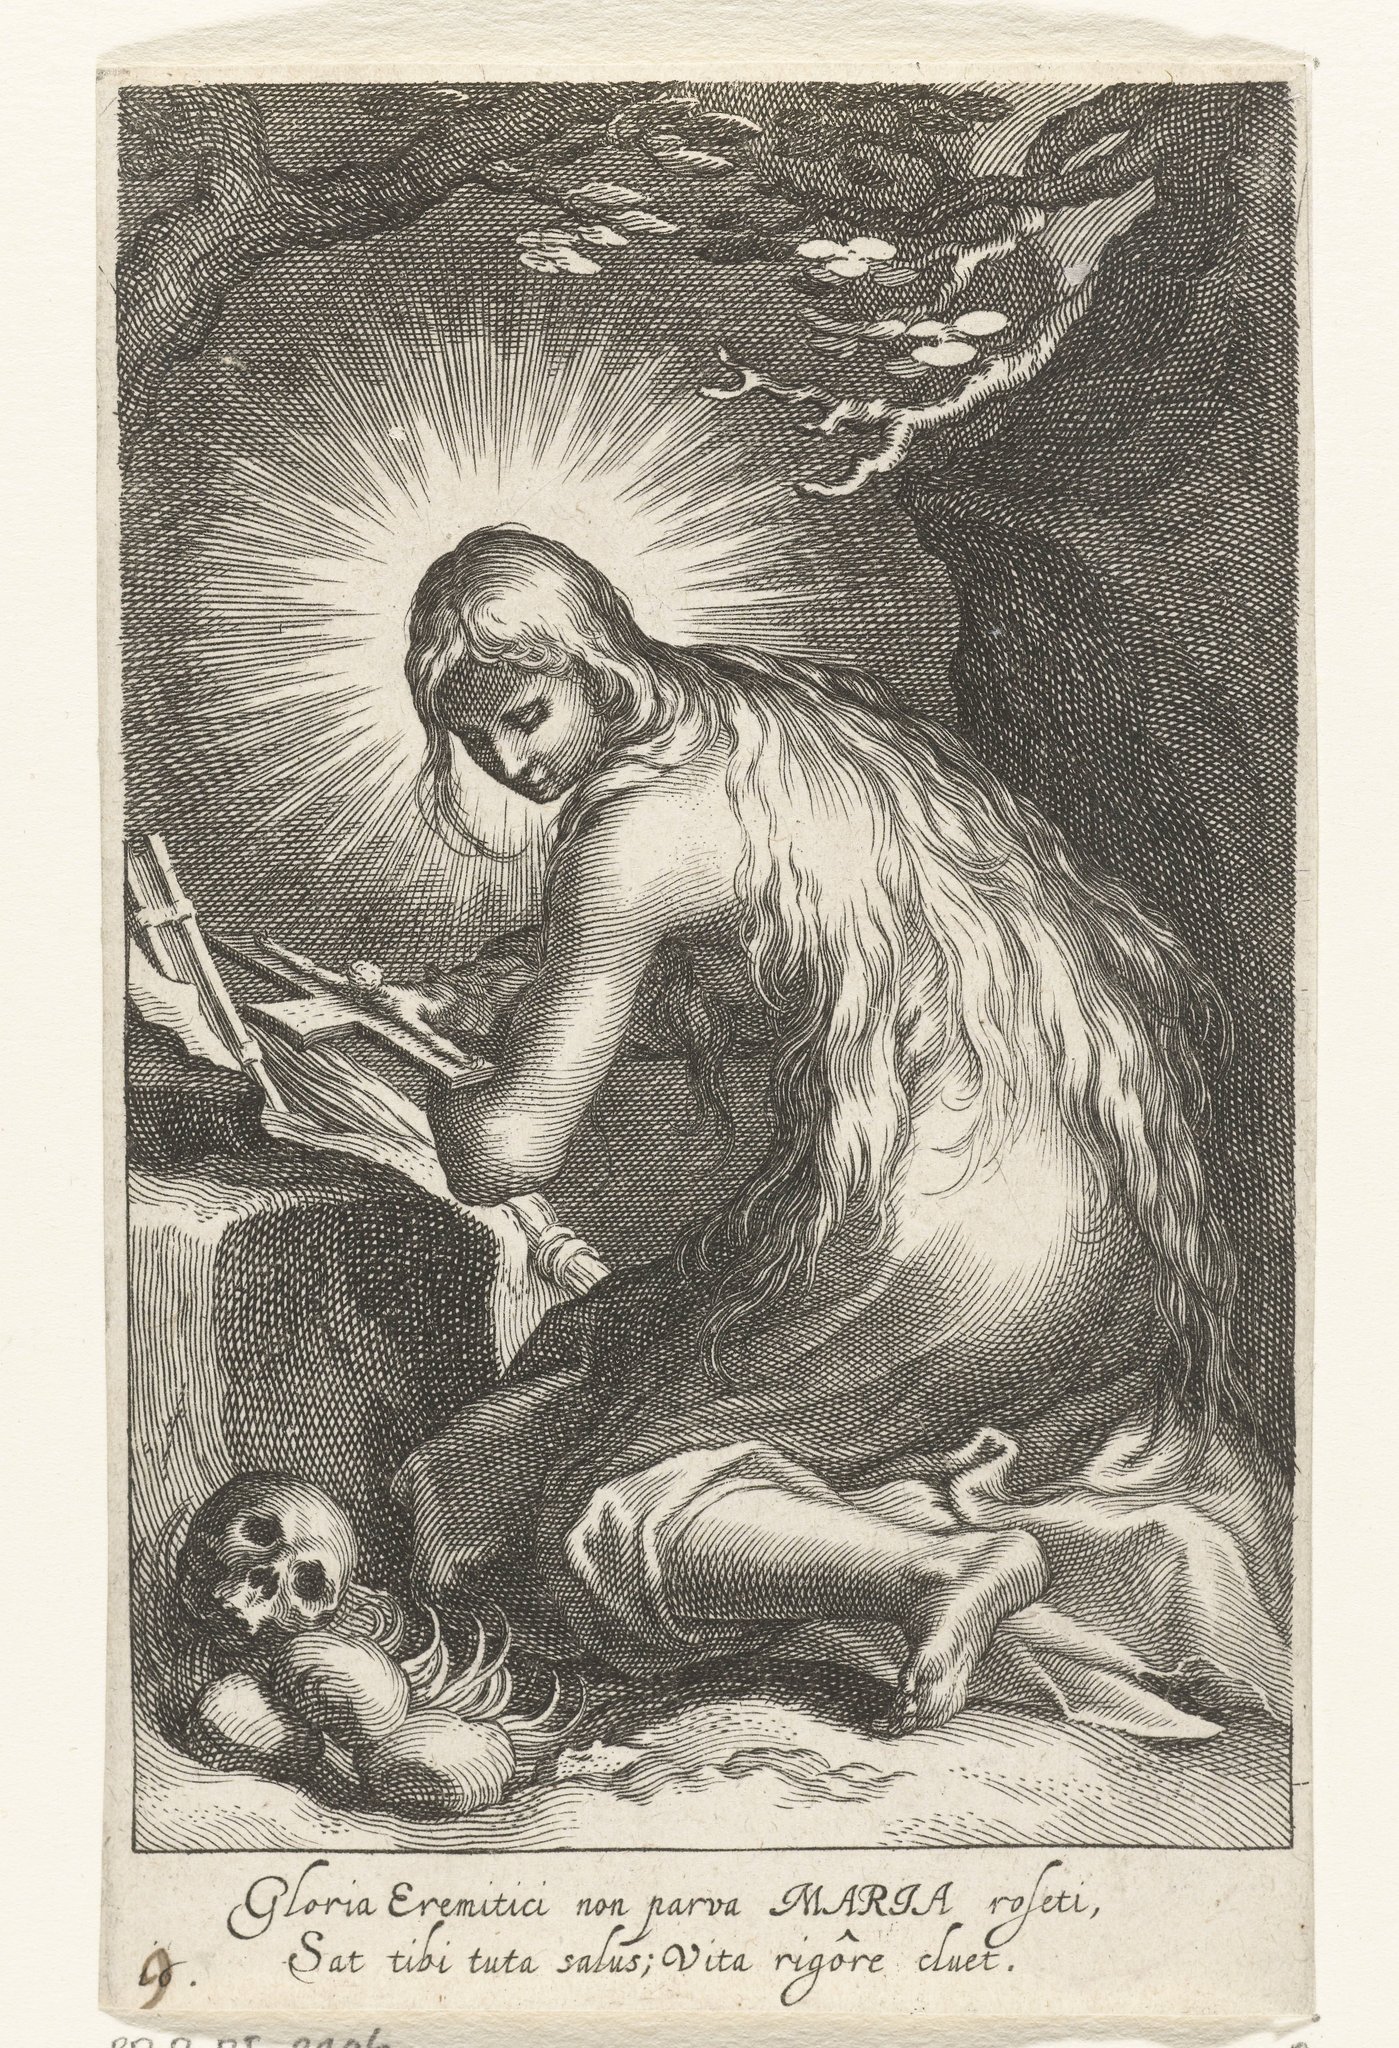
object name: print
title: Kluizenaressen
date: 1590-1612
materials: paper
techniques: engraving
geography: antwerp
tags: the penitent harlot mary of egypt (maria aegyptiaca); possible attributes: long hair, three loaves, anchorite, hermit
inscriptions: number: ‘9’, collector's mark: Lugt 240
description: Prent uit: Sacra Eremus Ascetriarum, uitgever Boëtius Adamsz. Bolswert, 1612 of Hendrik Aertssen, Antwerpen 1619. Prent uit de serie van vijfentwintig kluizenaressen in deze uitgaven. In 1612 verscheen een ongebonden editie maar op basis van de gewijzigde opschriften en samenstelling van de serie kluizenaars wordt aangenomen dat de prenten van de uitgave 1619 ook in 1612 of iets daarvoor gedrukt werden. De serie kluizenaressen bleef vrijwel ongewijzigd in de ongebonden uitgave van 1612, dit compliceert de datering van de losse bladen in de collectie van het RMA, zie Roethlisberger 1993, p. 171-175.